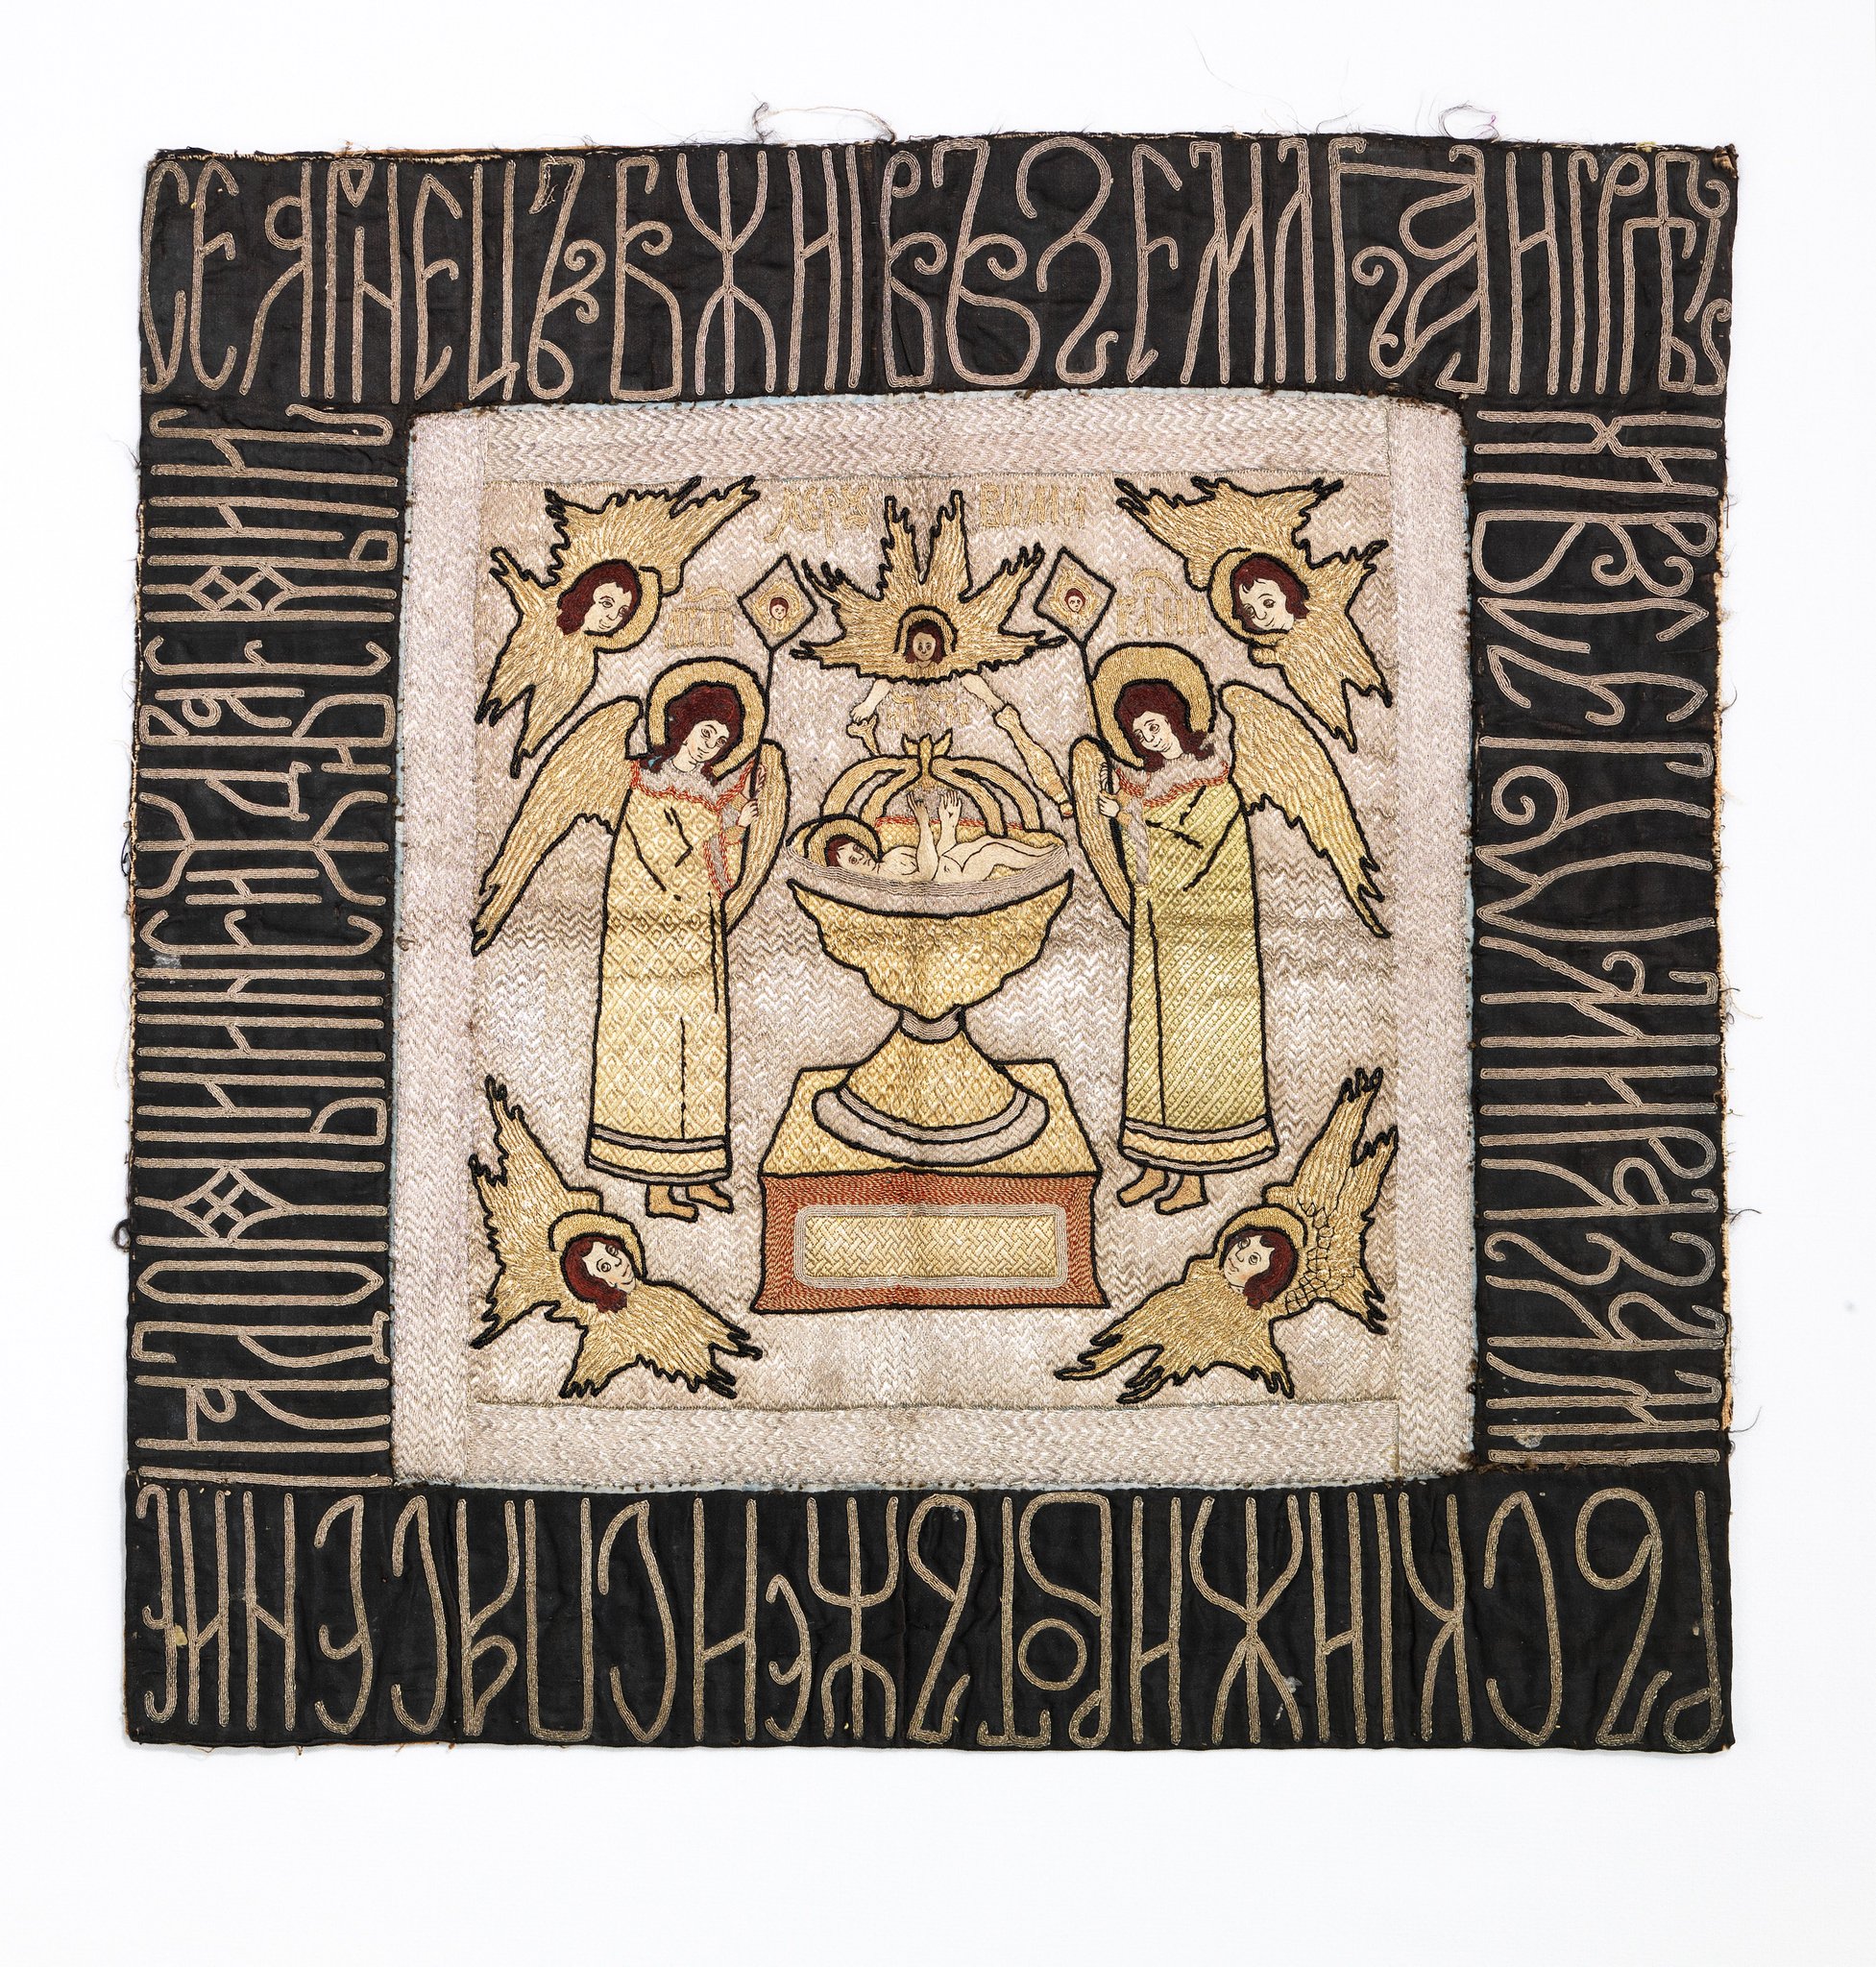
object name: chalice cover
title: Chalice veil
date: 1501-1600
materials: metal, silk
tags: angels,christ